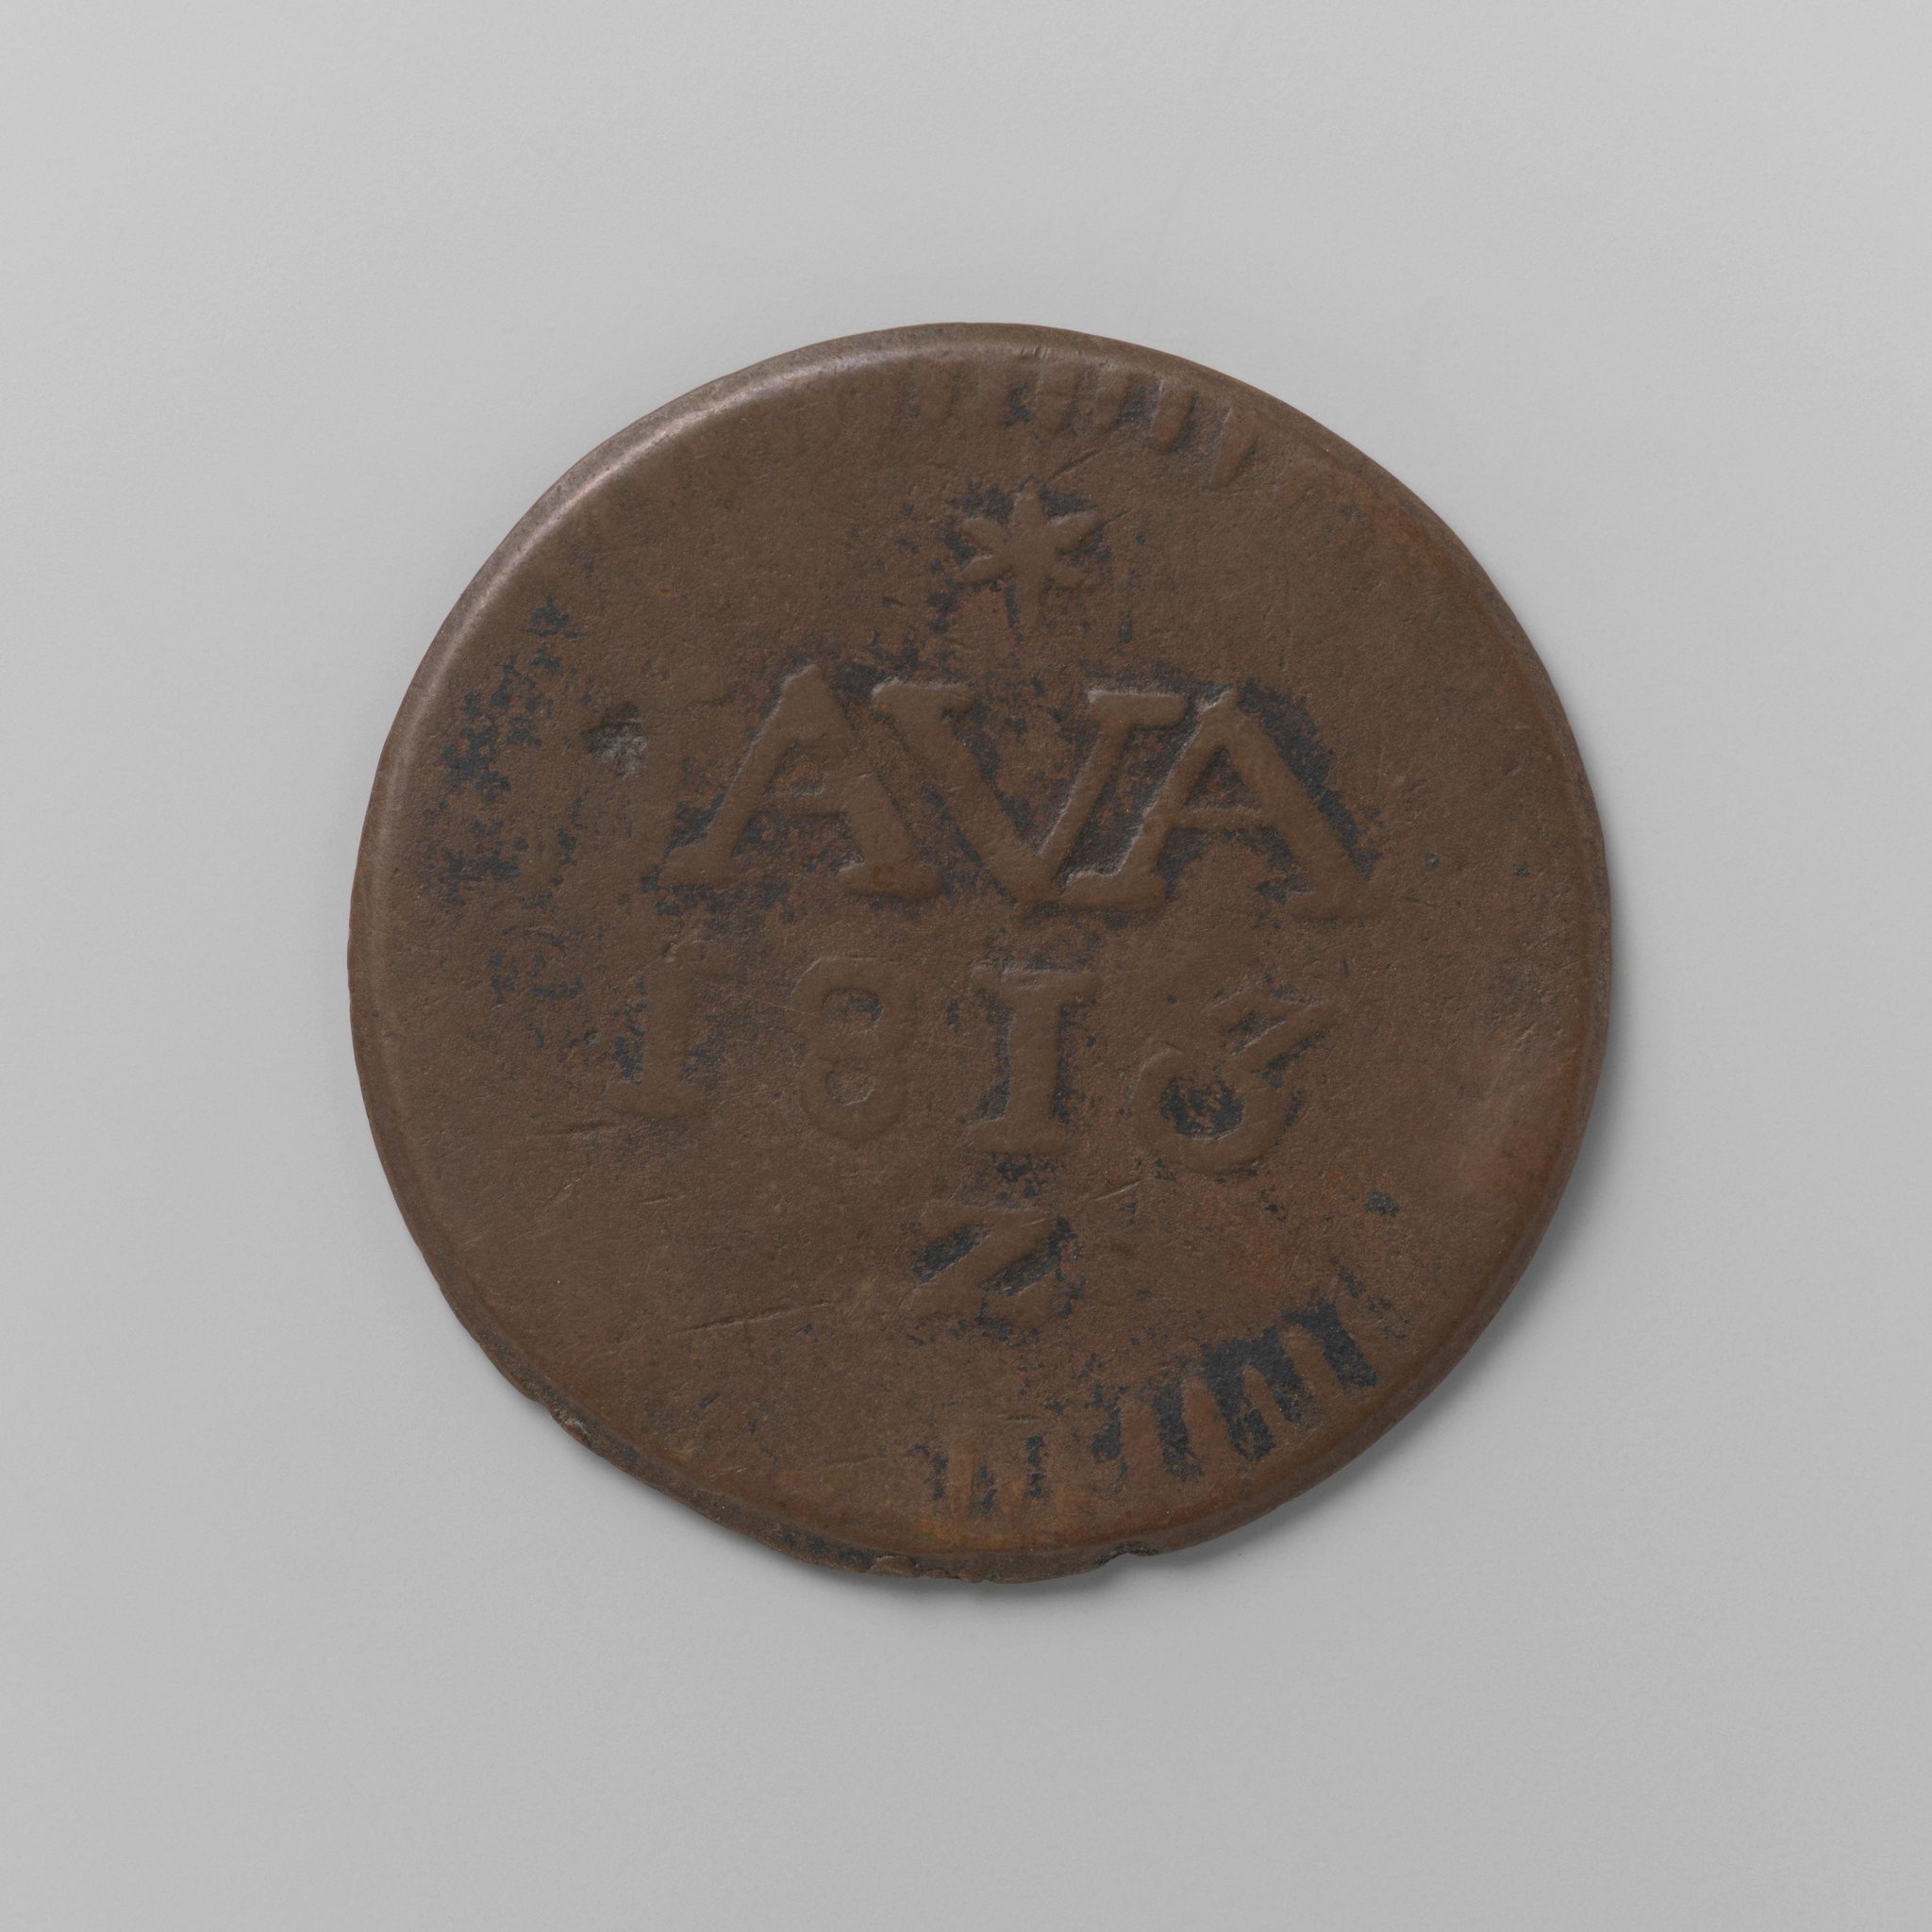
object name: coin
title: Nederlands Indië tijdens Brits bestuur, ½ stuiver Java,1813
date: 1813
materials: copper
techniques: striking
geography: surabaya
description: Koperen munt. Voorzijde: tussen waarde-aanduiding ½ St monogram van de Engelse Oostindische Compagnie. Daarboven letter B [=British]. Keerzijde: eenregelig opschrift, waaronder jaartal. Boven opschrift muntteken en onder jaartal muntmeesterteken Z [=muntmeester Zwekkert].